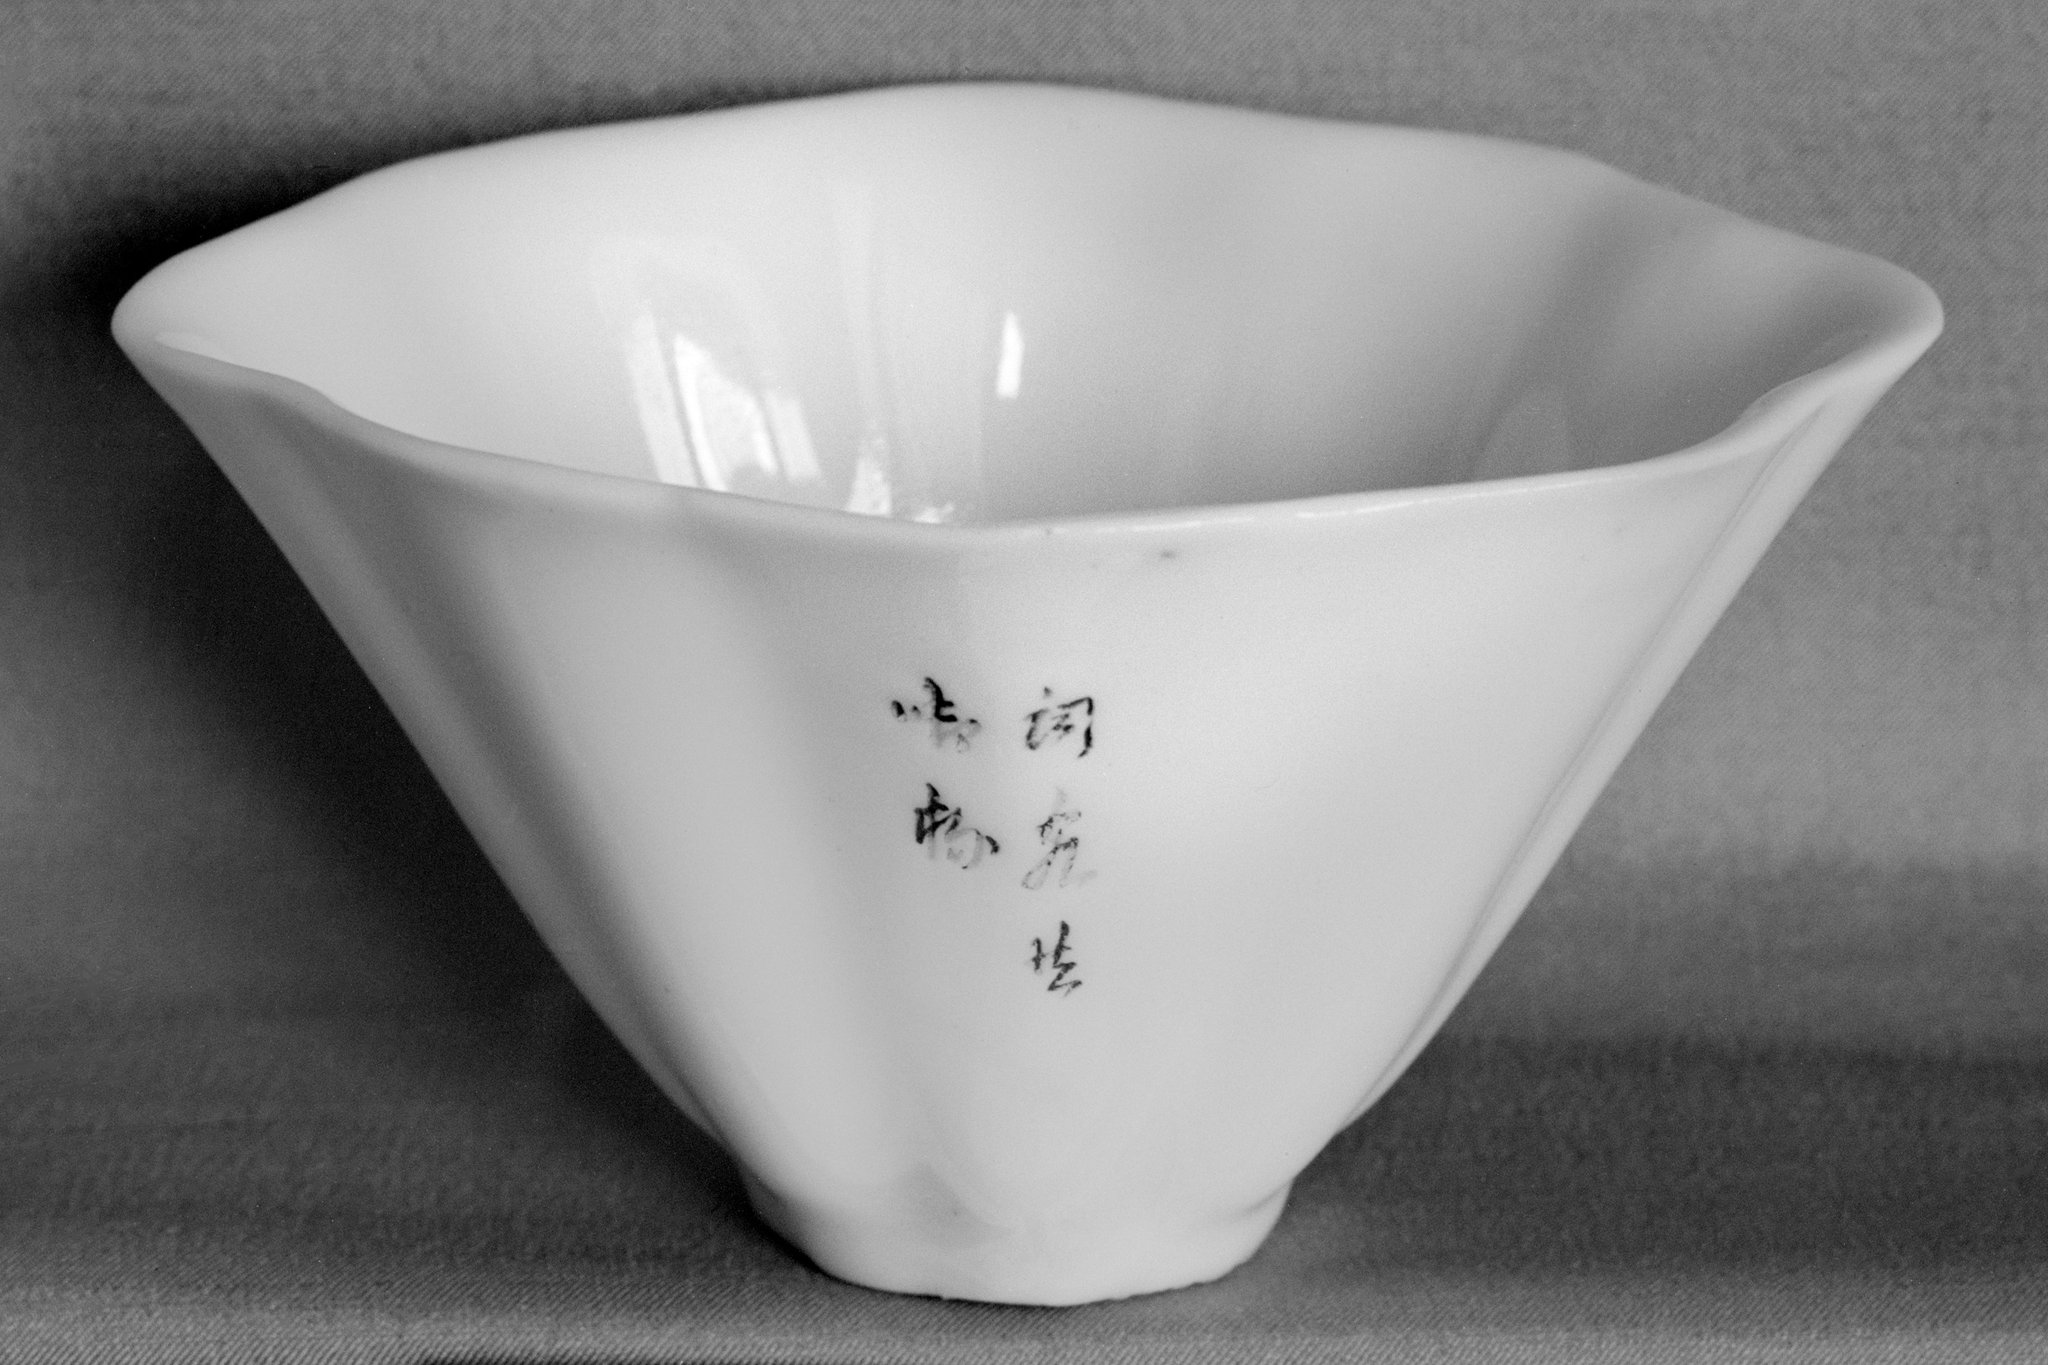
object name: cup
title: Cup with poem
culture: chinese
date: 1667-1733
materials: porcelain